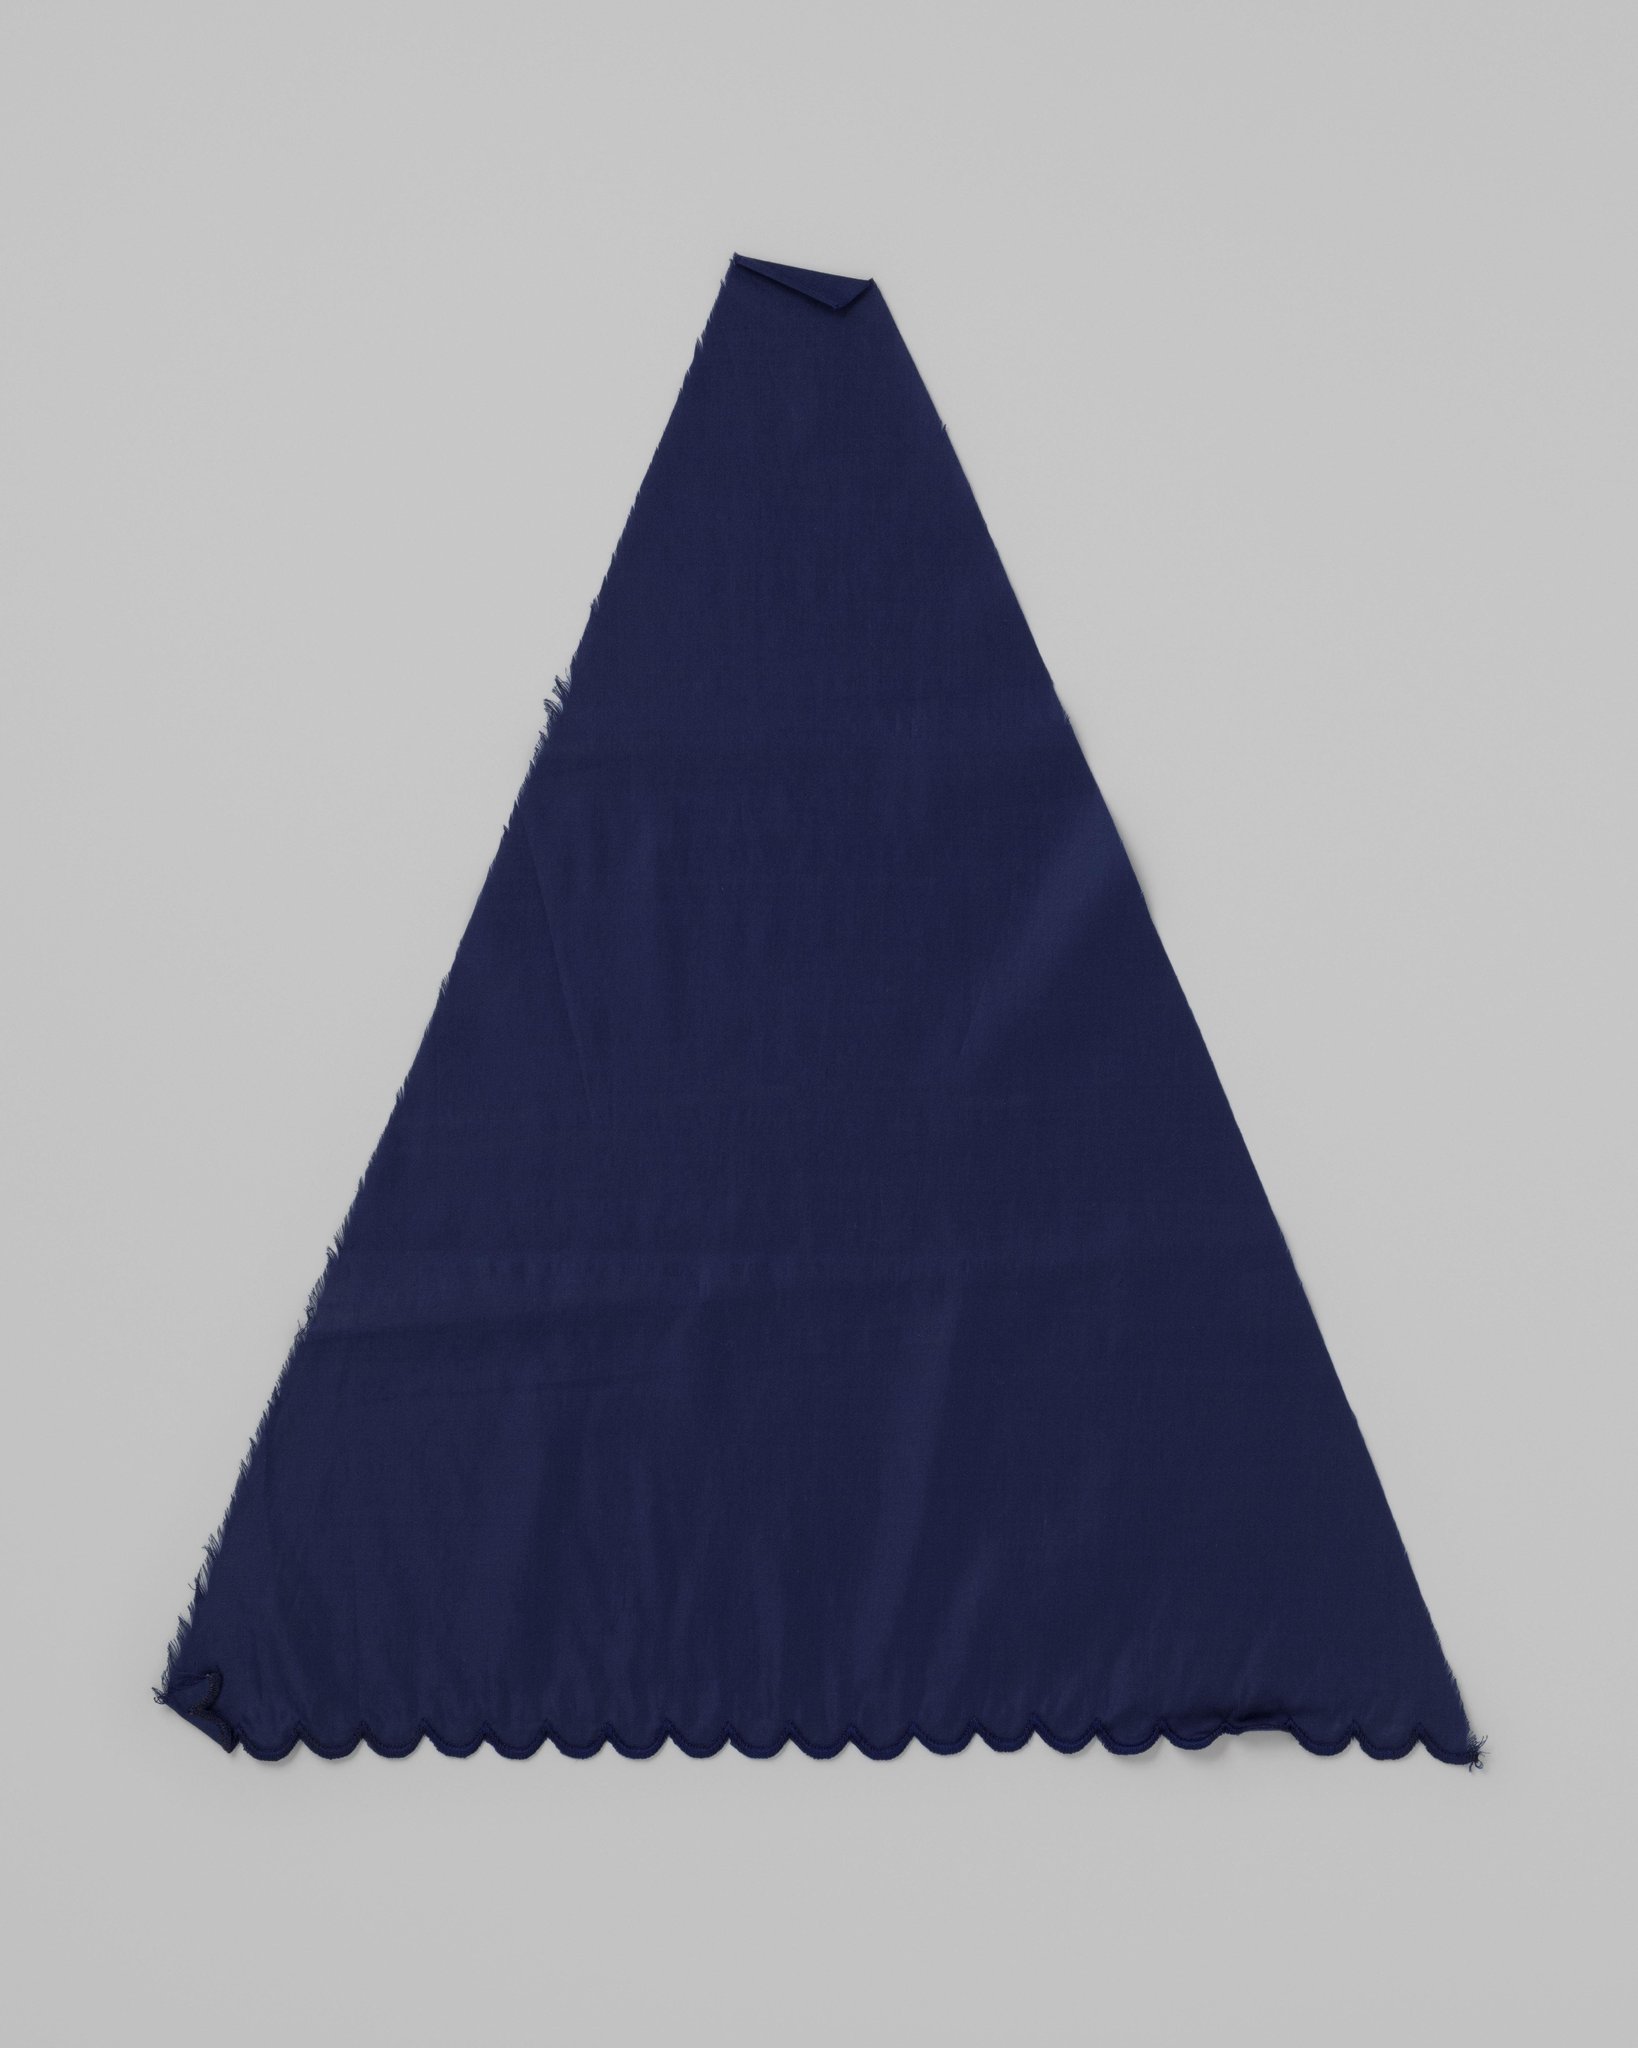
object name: parasoldek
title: Sector van een parasoldek van ultramarijn katoen; met geschulpte rand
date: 1885-1900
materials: cotton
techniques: festoon stitch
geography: nijmegen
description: Zes in acht sectoren geknipte parasoldekjes van katoen. B. Ultramarijn.